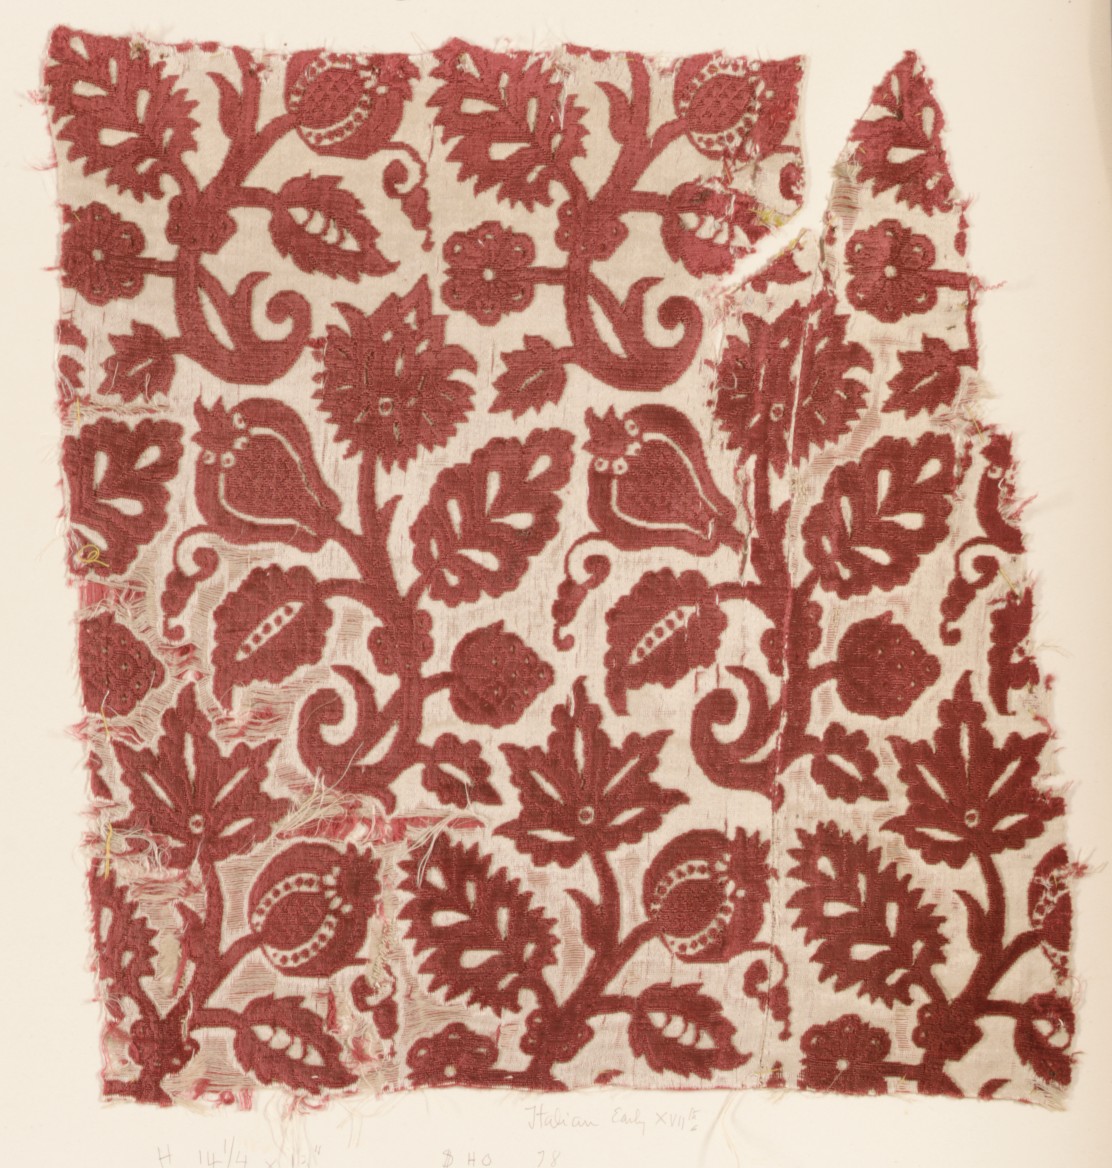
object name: fragment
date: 1701-1733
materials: silk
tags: flowers,leaves